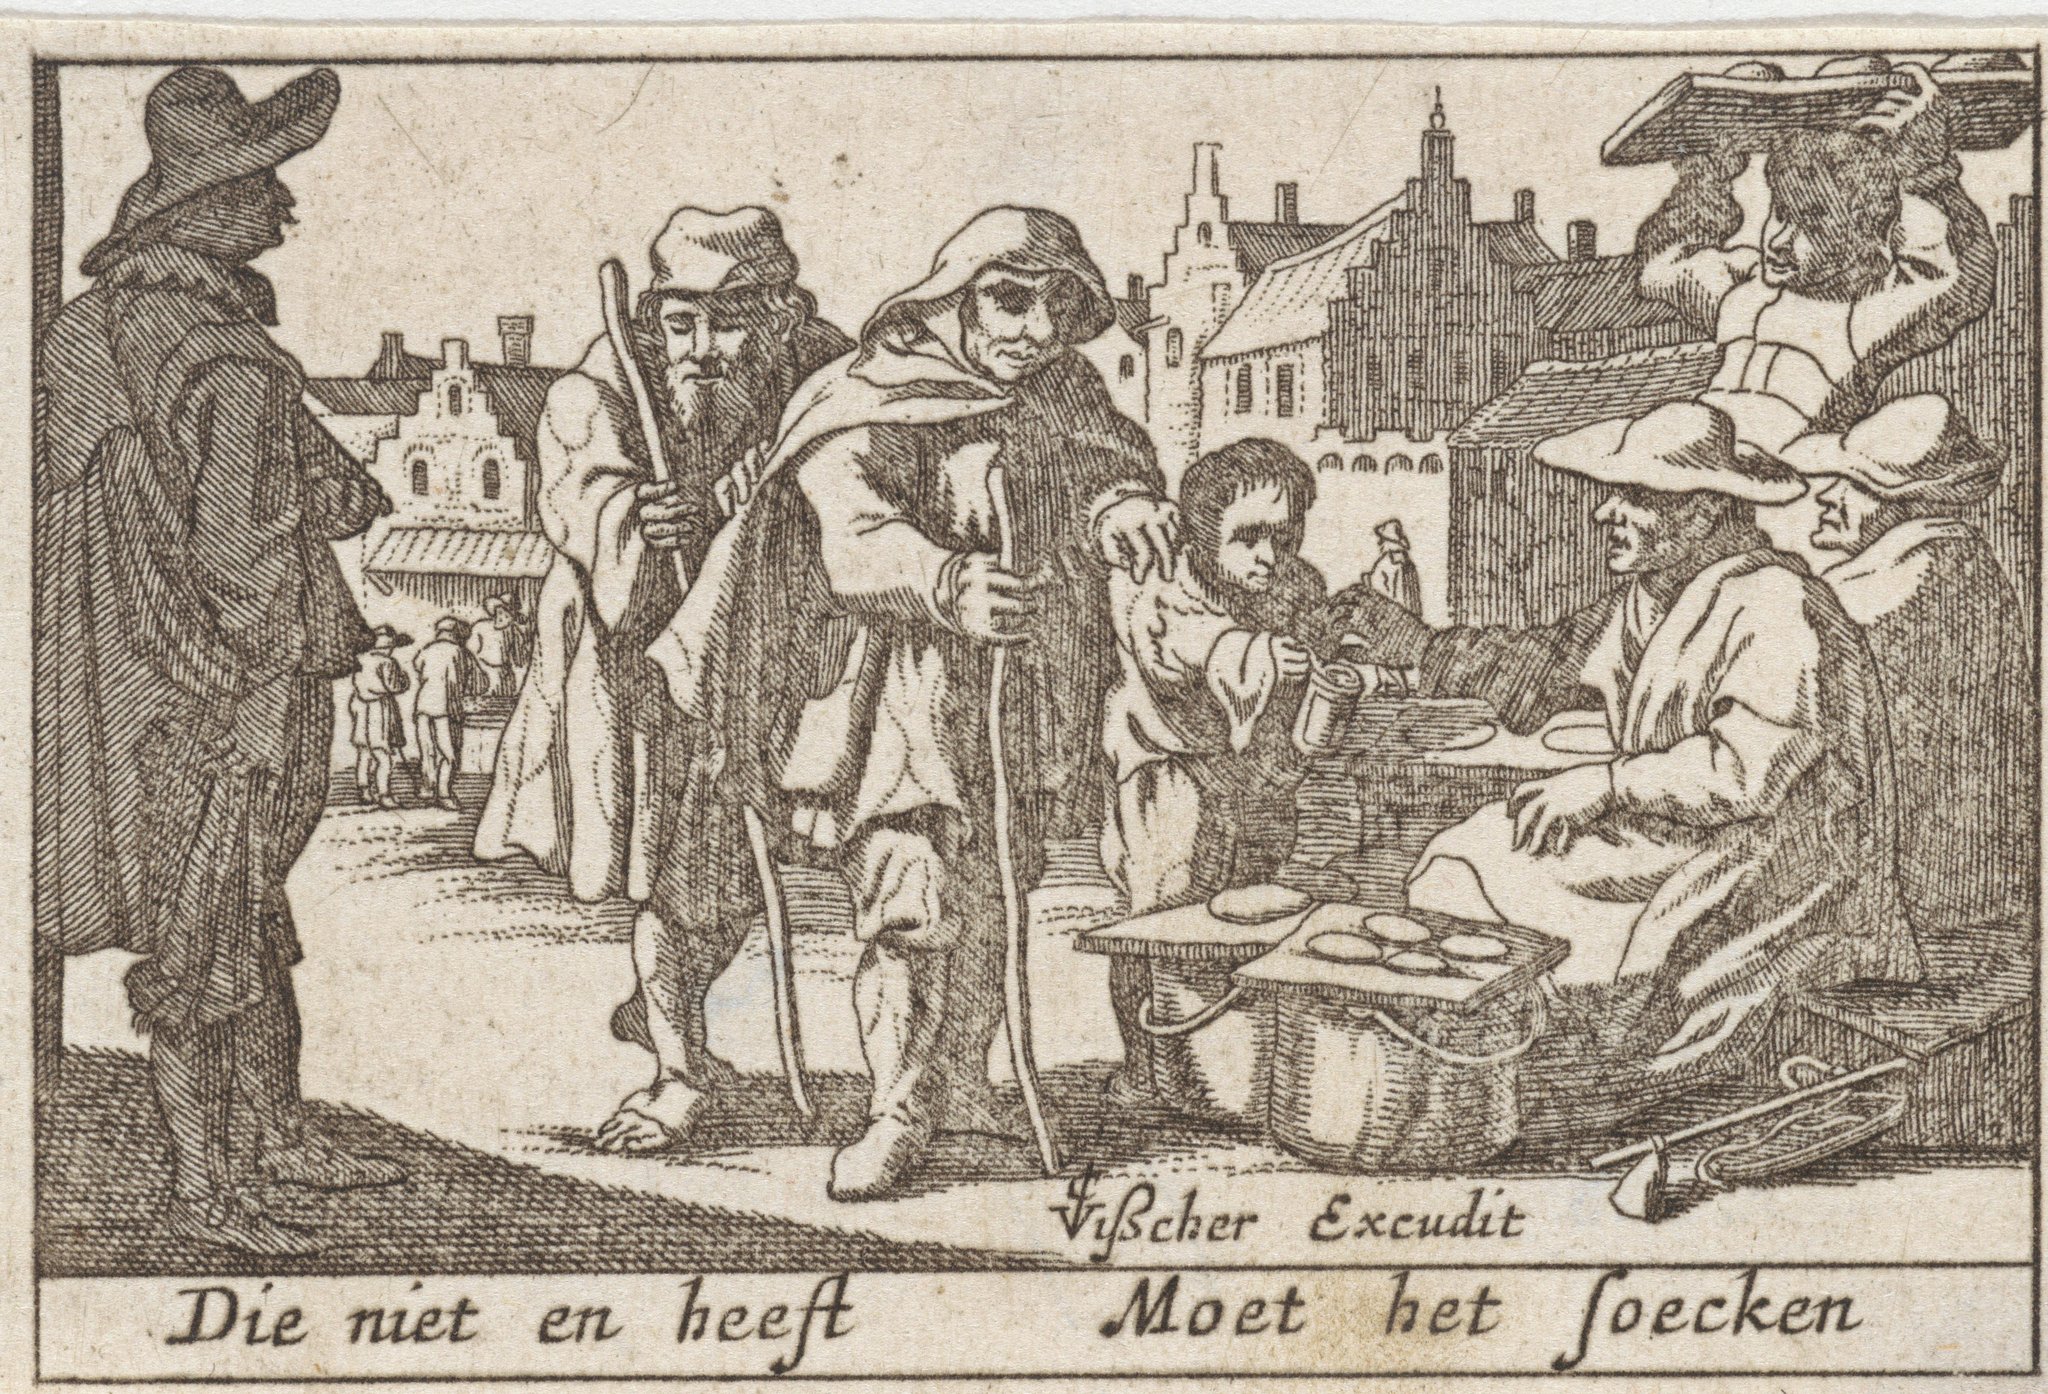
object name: print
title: Die niet en heeft Moet het soecken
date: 1628-1650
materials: paper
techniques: etching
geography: amsterdam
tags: giving alms or other charity, e.g.: handing out food, street-trader, beggar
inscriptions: collector's mark: Lugt 2228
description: Brood- of koekverkoopster, zittend op markt. Naast haar staat een bakker met een plank vol broodjes op zijn hoofd. Voor haar drie blinde bedelaars die om een aalmoes vragen.